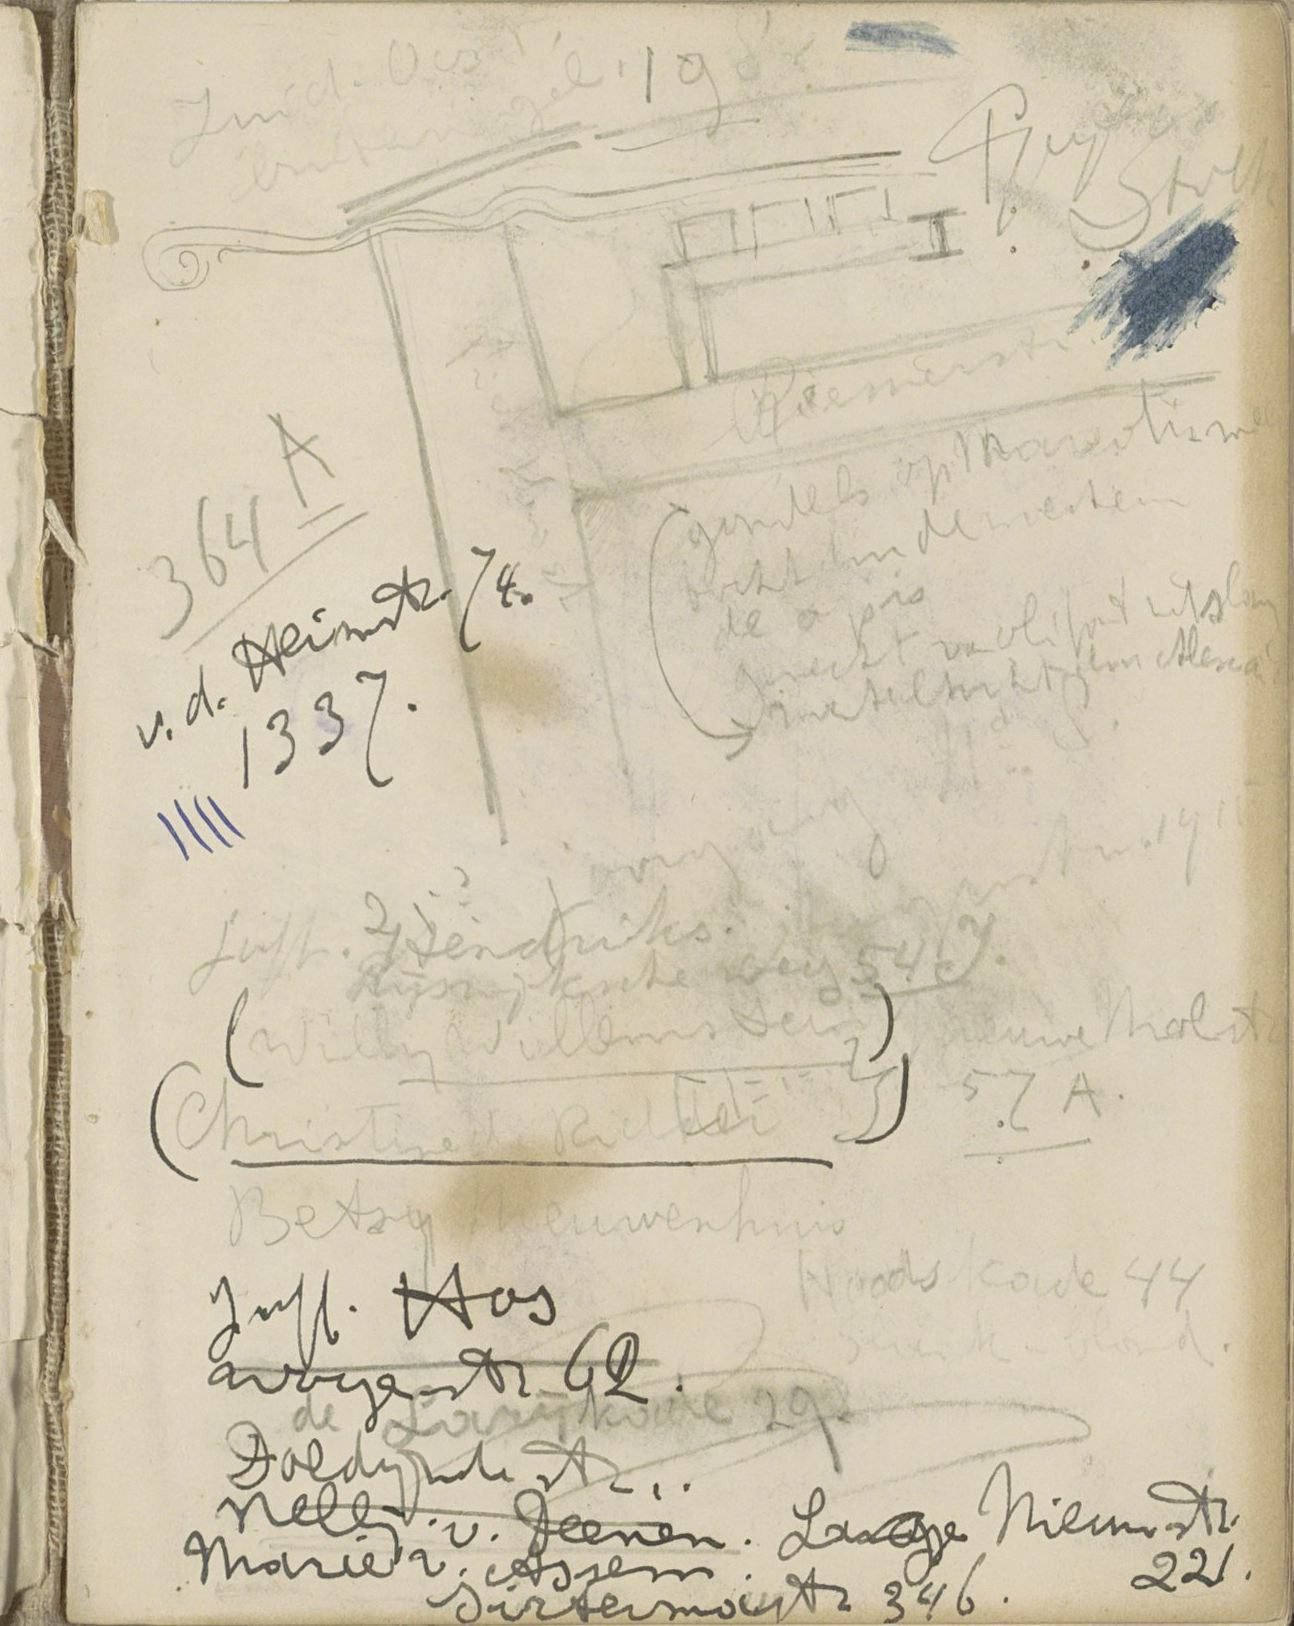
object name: sketchbook leaf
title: Studie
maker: reijer stolk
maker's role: draughtsman, print maker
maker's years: 1896-1945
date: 1906-1945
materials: ink, paper, pencil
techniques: pen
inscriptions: annotation: ‘Zuid-Oost/ Buitensingel 1981/ Reyer/ Stolk/ Riemerstr/ [...]’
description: Mogelijk architectuur. Blad 1 recto uit een schetsboek met 69 bladen.